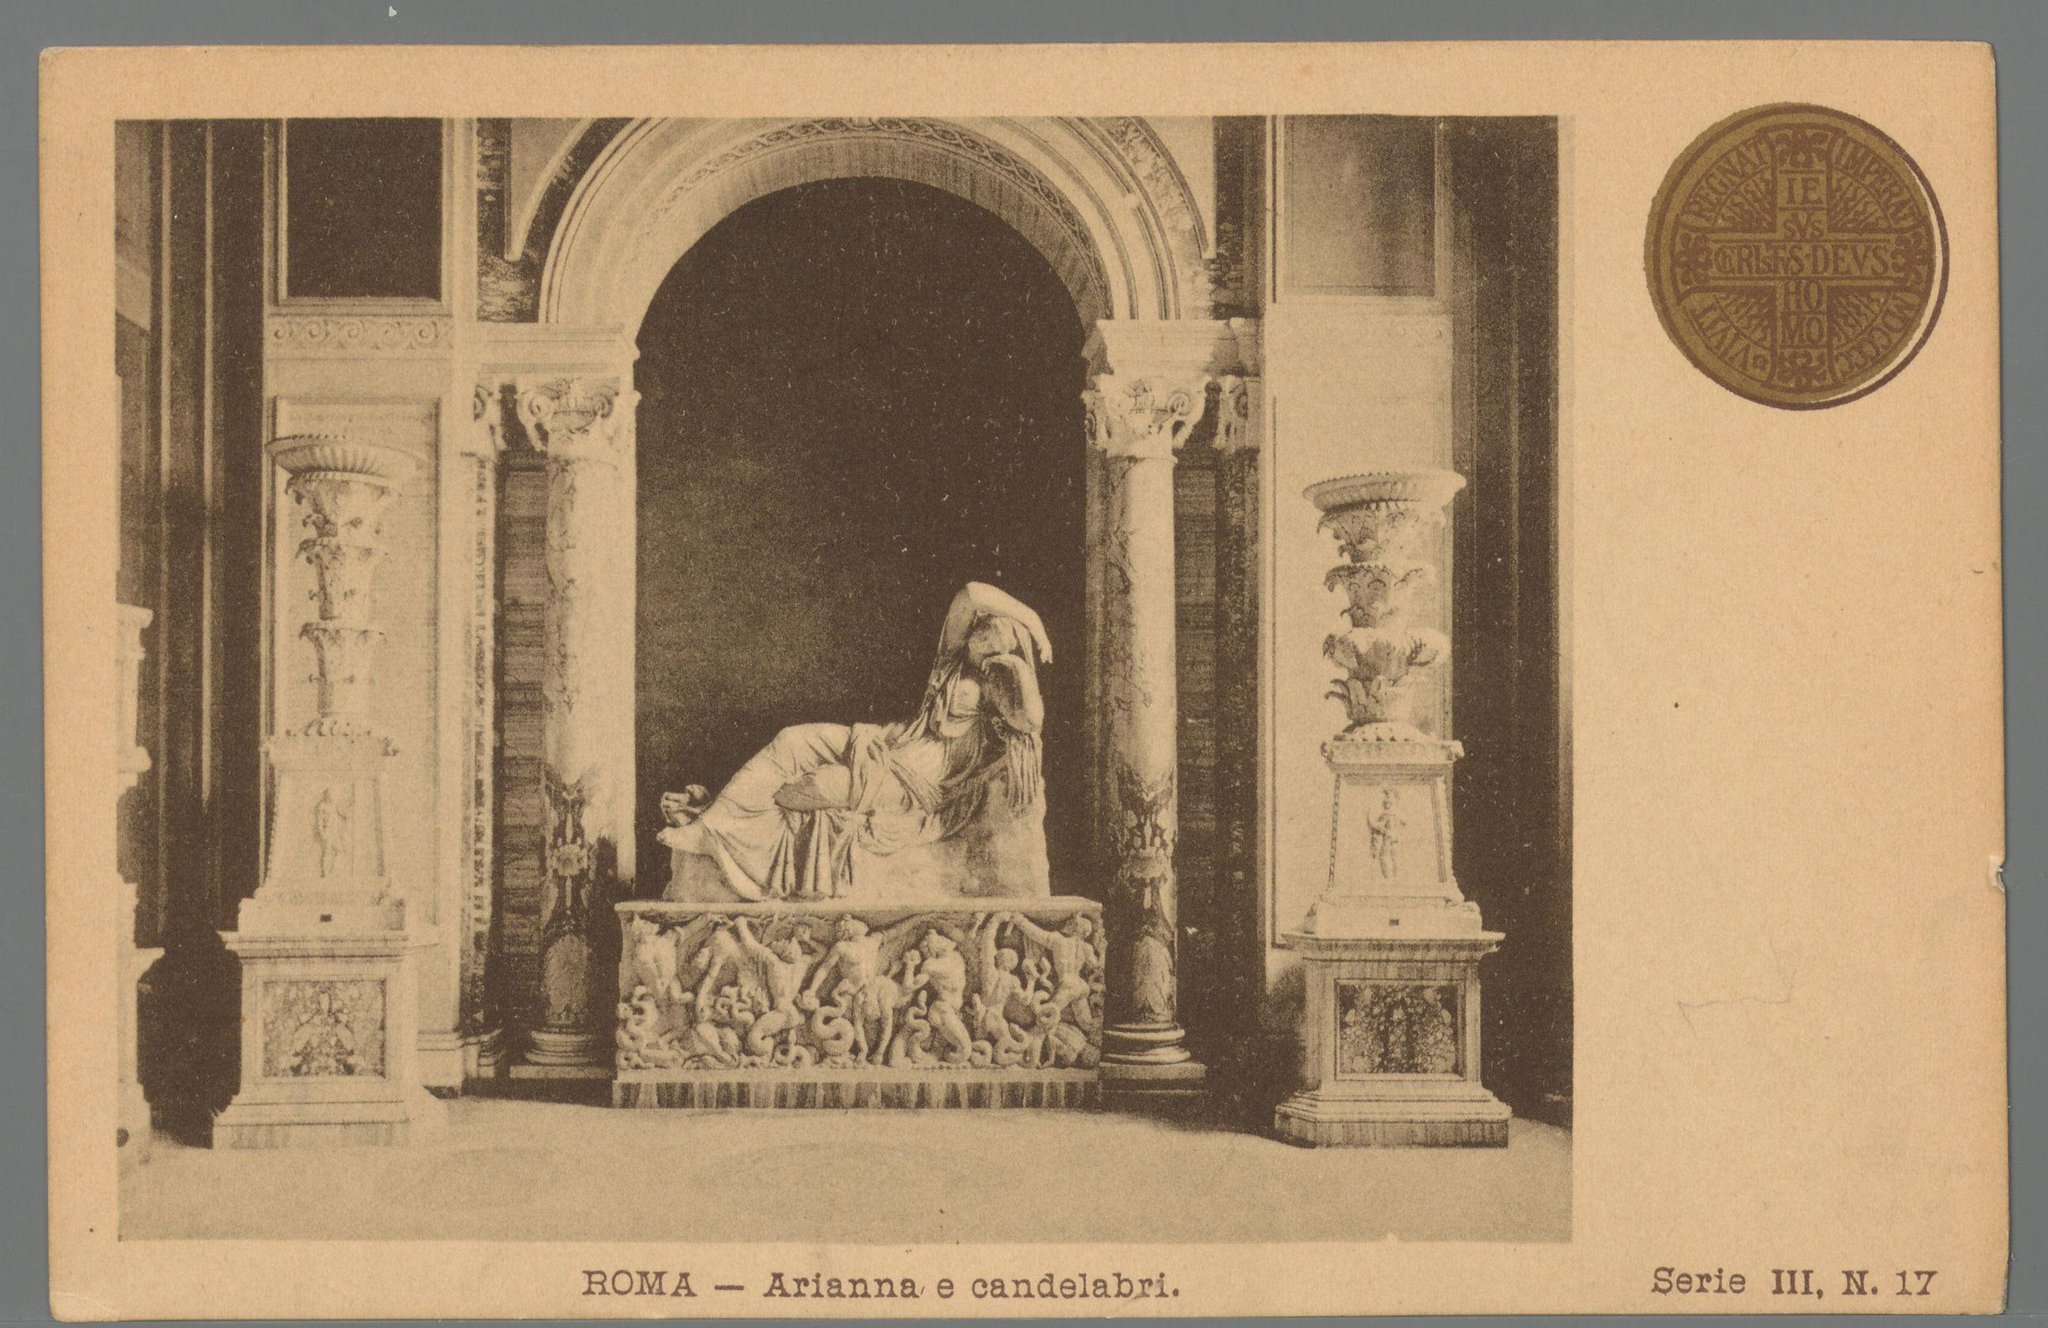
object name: photomechanical print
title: Roma. Arianna e candelabri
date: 1900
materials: cardboard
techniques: photograph, lithograph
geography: rome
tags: permanent exhibition, museum, sculpture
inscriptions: date